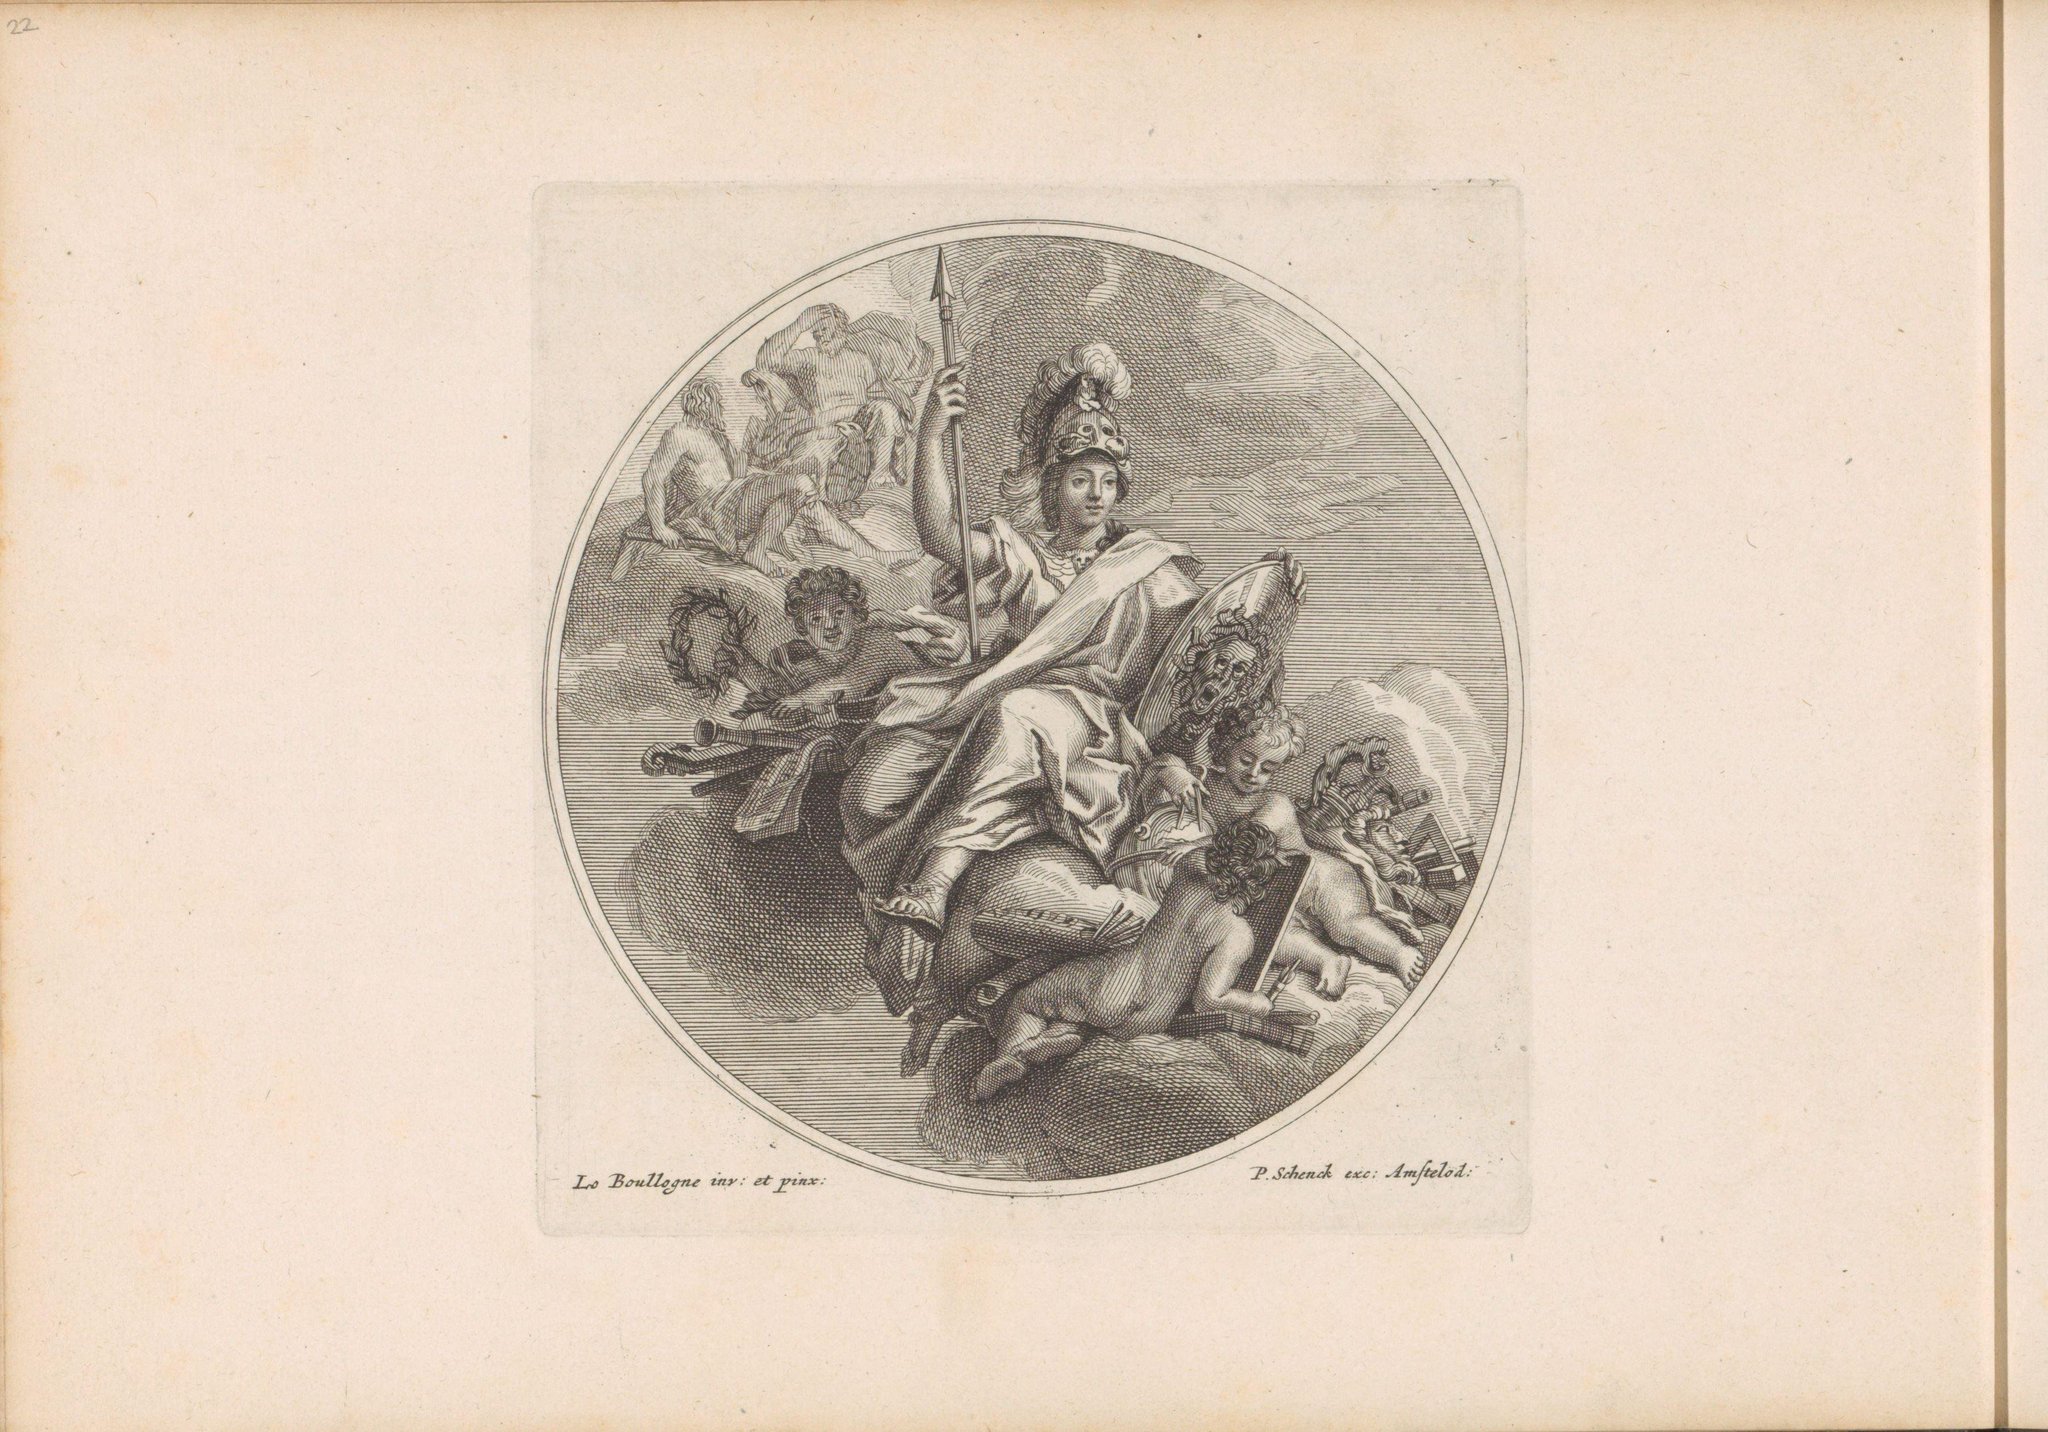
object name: album leaf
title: Le Cabinet des Beaux Arts (...) / De Schatkamer der Vrye Konsten (...)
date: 1693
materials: paper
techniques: engraving, etching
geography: amsterdam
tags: (story of) minerva (pallas, athena), birth of minerva; she emerges fully armed from jupiter's head, (decorated) ceiling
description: Plafondstuk met de godin Minerva, tronend op de wolken met helm, speer en schild. Rondom haar putti met attributen van de kunsten en de wetenschappen. Op de achtergrond de god Jupiter, die naar zijn hoofd grijpt. Minerva werd uit zijn hoofd geboren. Prent maakt deel uit van een album.